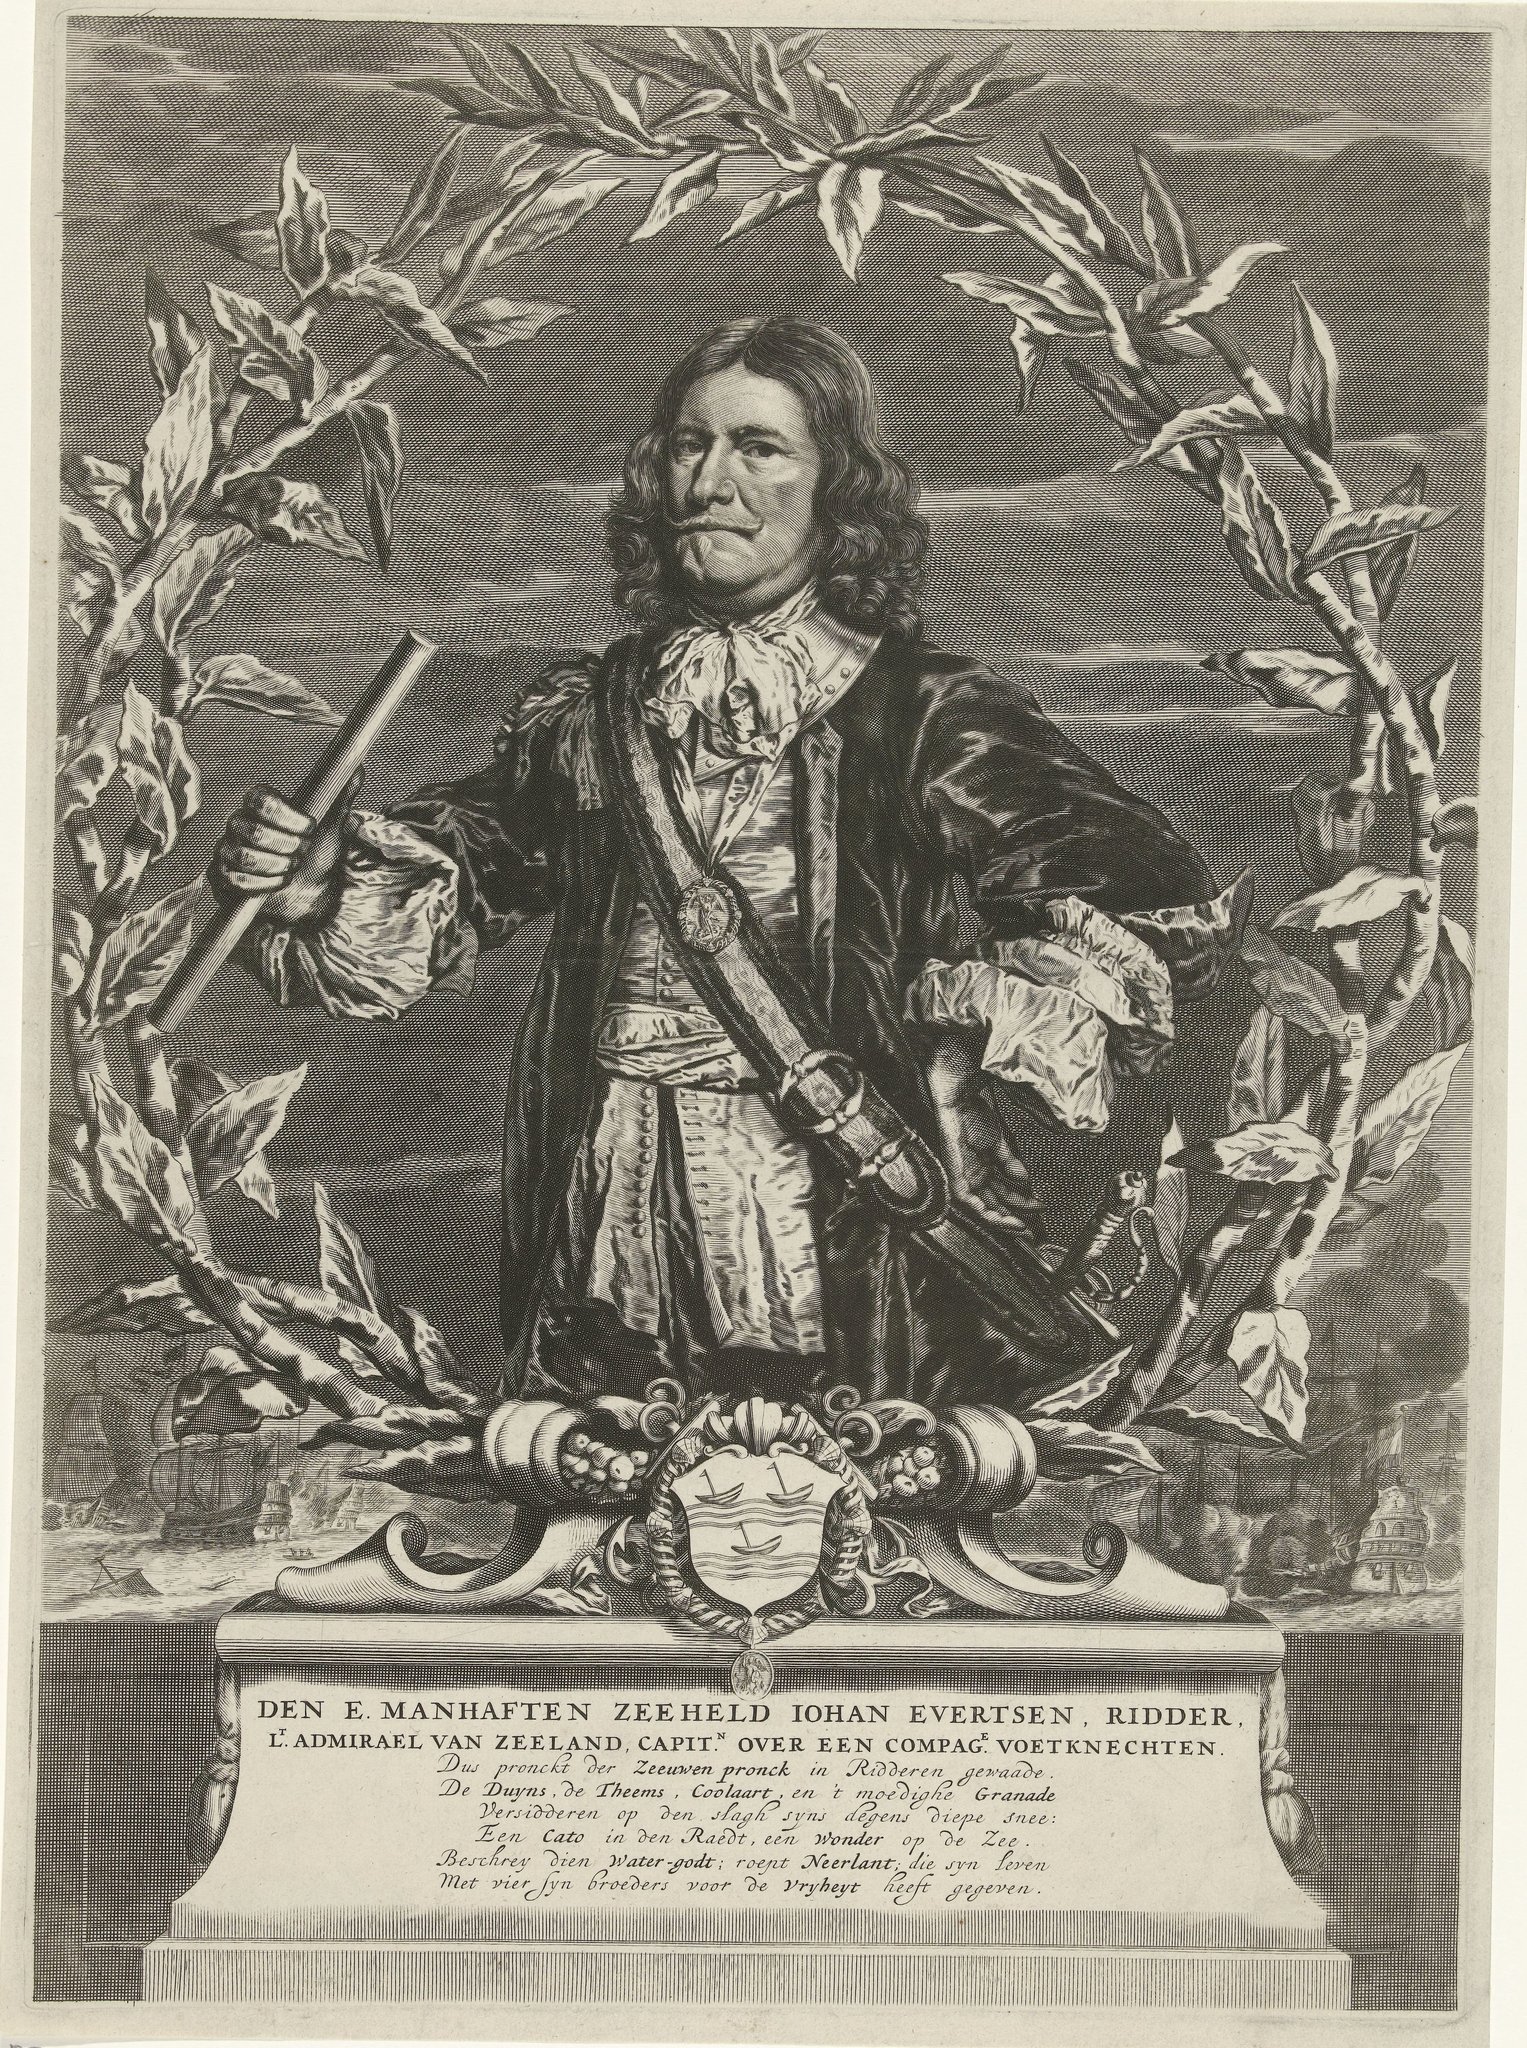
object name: print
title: Portret van Johan Evertsen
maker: arnold de jode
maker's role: print maker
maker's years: 1638-1669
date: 1666-1669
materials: paper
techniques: engraving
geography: london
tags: flushing, battle (+ naval force), historical persons, battle of st. james's day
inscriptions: collector's mark: Lugt 240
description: Portret van Johan Evertsen, admiraal van Zeeland. Op de achtergrond een zeegevecht. Het portret is gevat in een lauwerkrans die rust op een piëdestal. Op de piëdestal de naam en functie van de geportretteerde en een zesregelig onderschrift in het Nederlands. Pendant van een portret van Cornelis Evertsen.